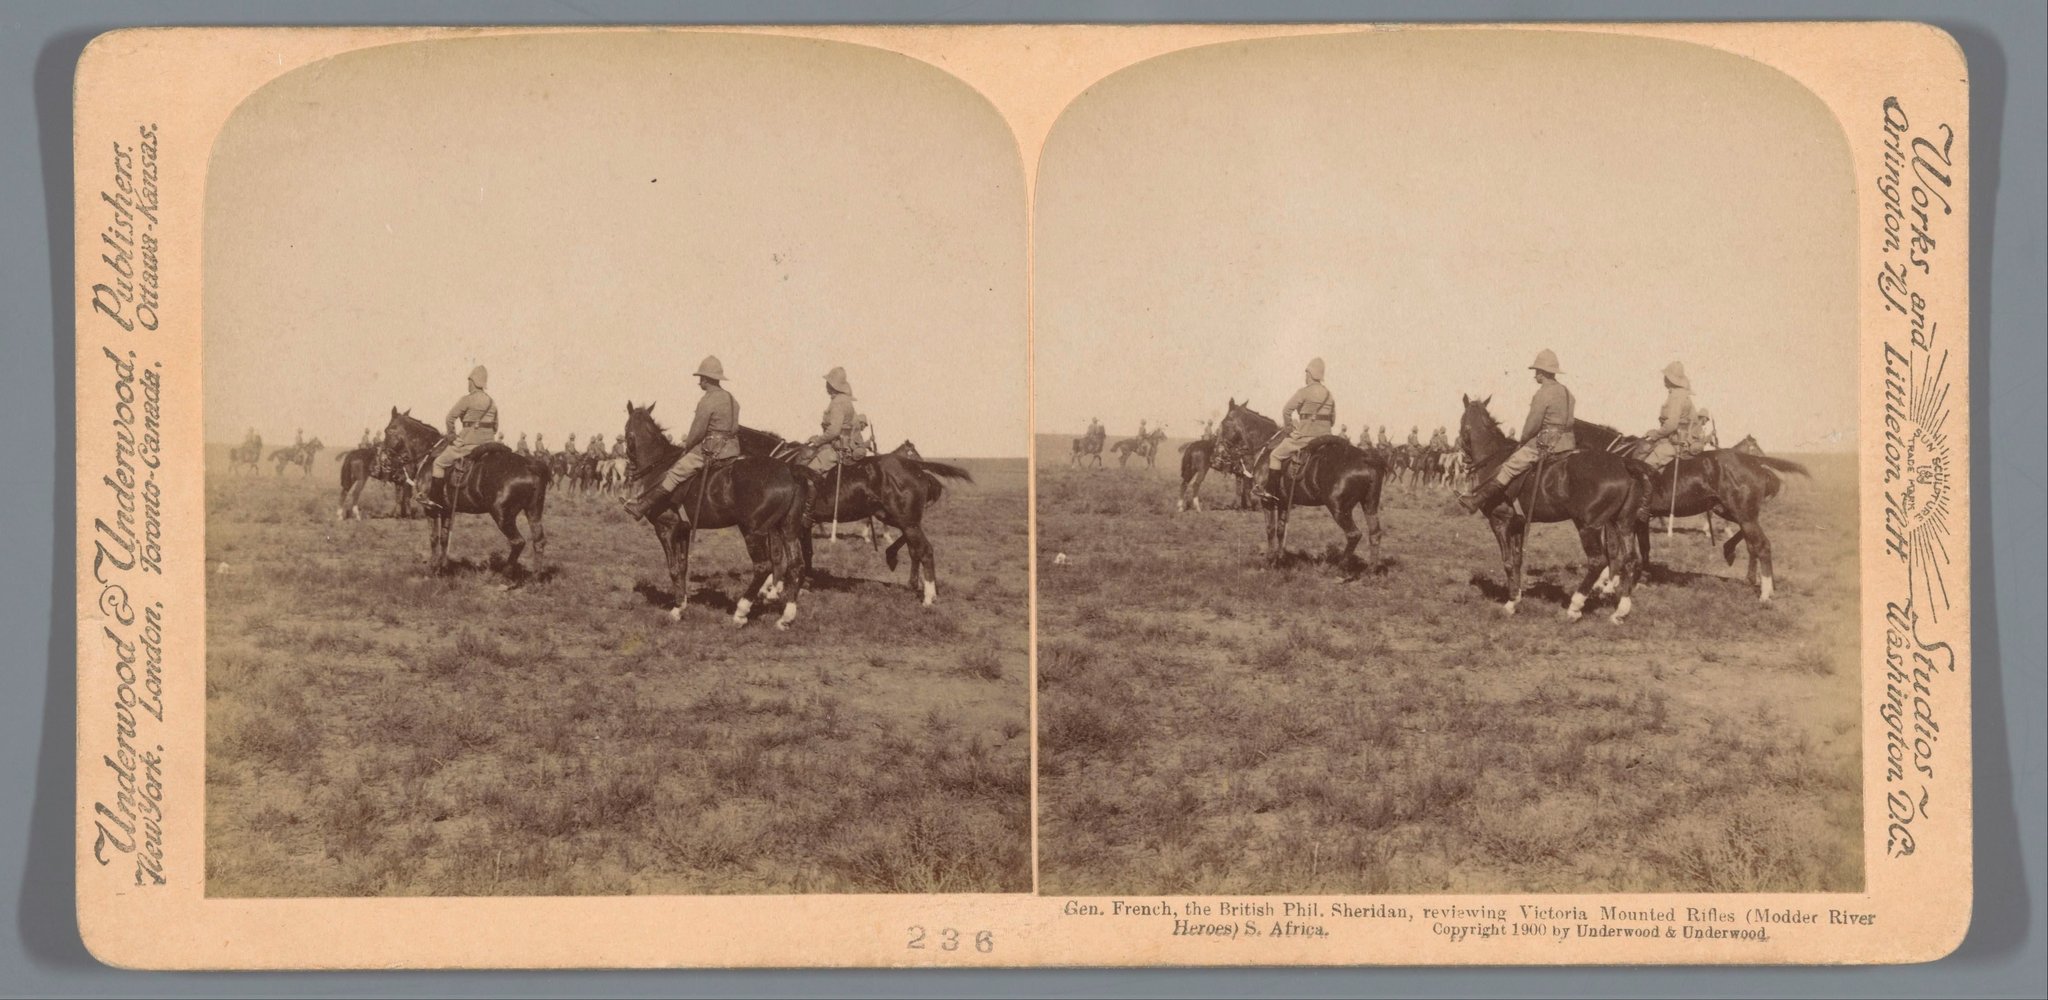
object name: stereograph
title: Gen. French, the British Phil. Sheridan, reviewing Victoria Mounted Rifles (Modder River Heroes), S. Africa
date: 1900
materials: cardboard, photographic support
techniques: albumen print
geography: south africa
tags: firearms: rifle, the soldier; the soldier's life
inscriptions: number: ‘236’, name: ‘Works and Studios Sun Sculpture trade mark Arlington N.J. Littleton N.H. Washington D.C.’